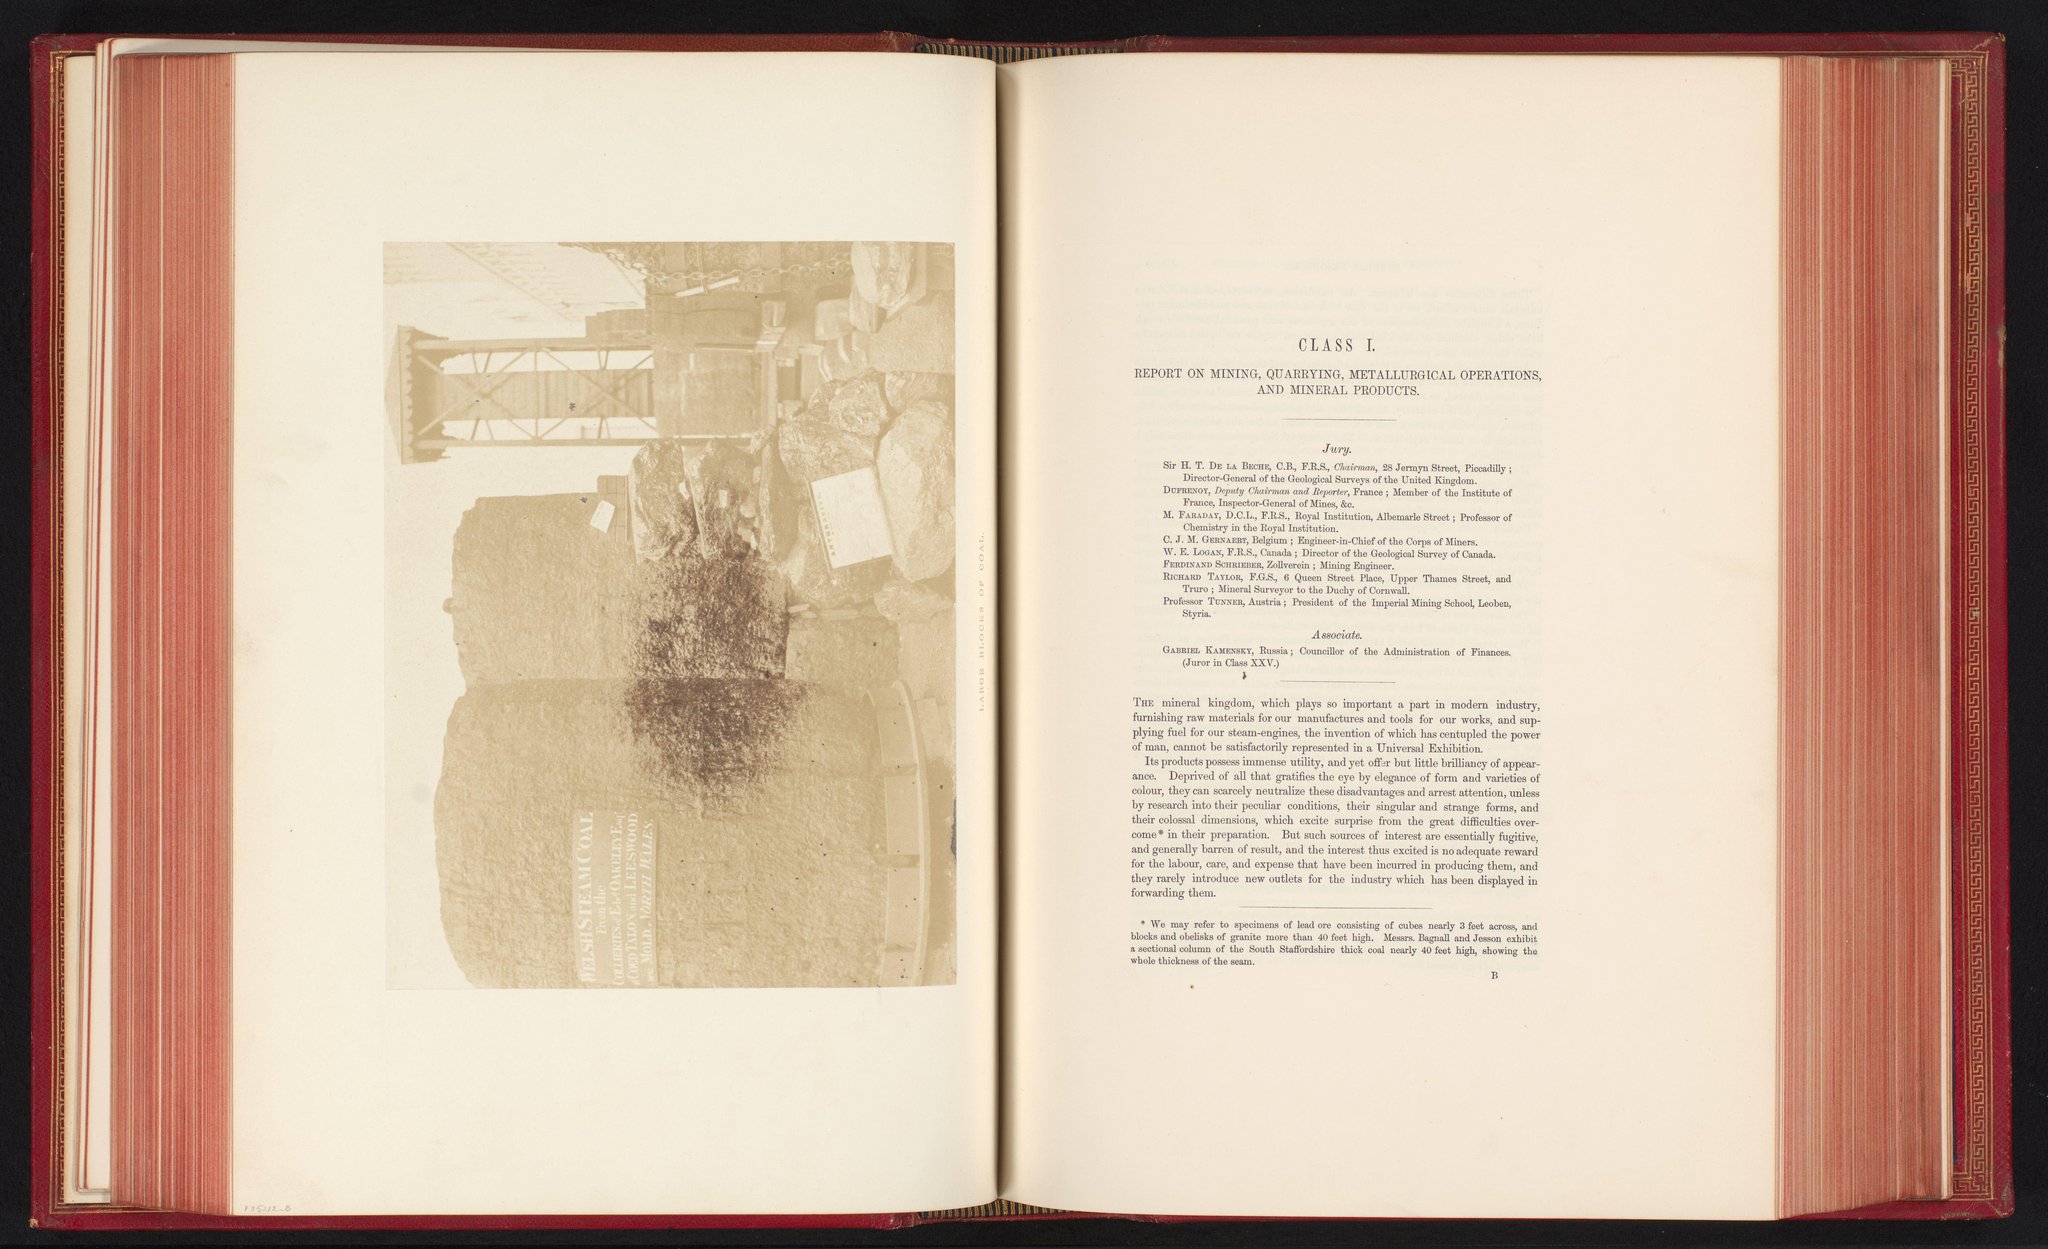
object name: photograph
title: Blokken steenkool bij de Great Exhibition of the Works of Industry of All Nations in 1851 in Londen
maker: hugh owen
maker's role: fotograaf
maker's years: 1808-1897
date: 1851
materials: photographic support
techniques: salted paper print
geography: london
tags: anthracite, hard coal, london